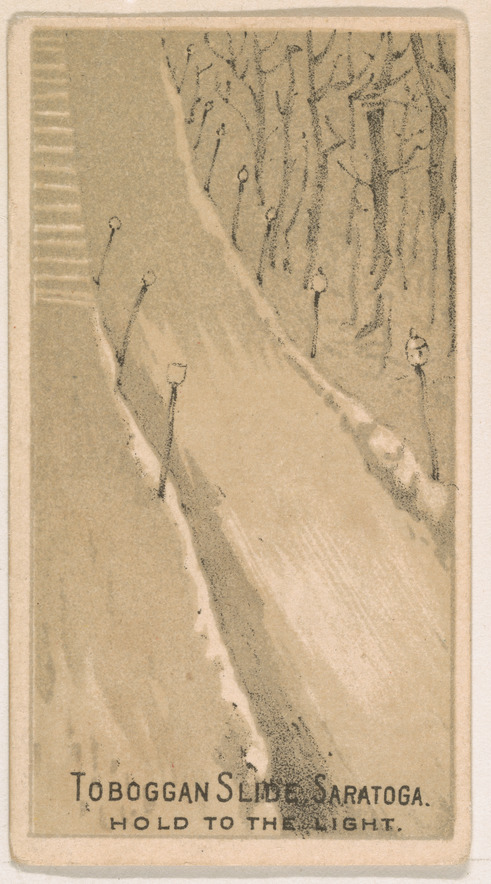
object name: print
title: Toboggan Slide, Saratoga, from the Magic Changing Cards series (N223) issued by Kinney Tobacco Company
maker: kinney brothers tobacco company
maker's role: publisher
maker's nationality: american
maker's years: 1869-2011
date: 1889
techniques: color lithograph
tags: roads